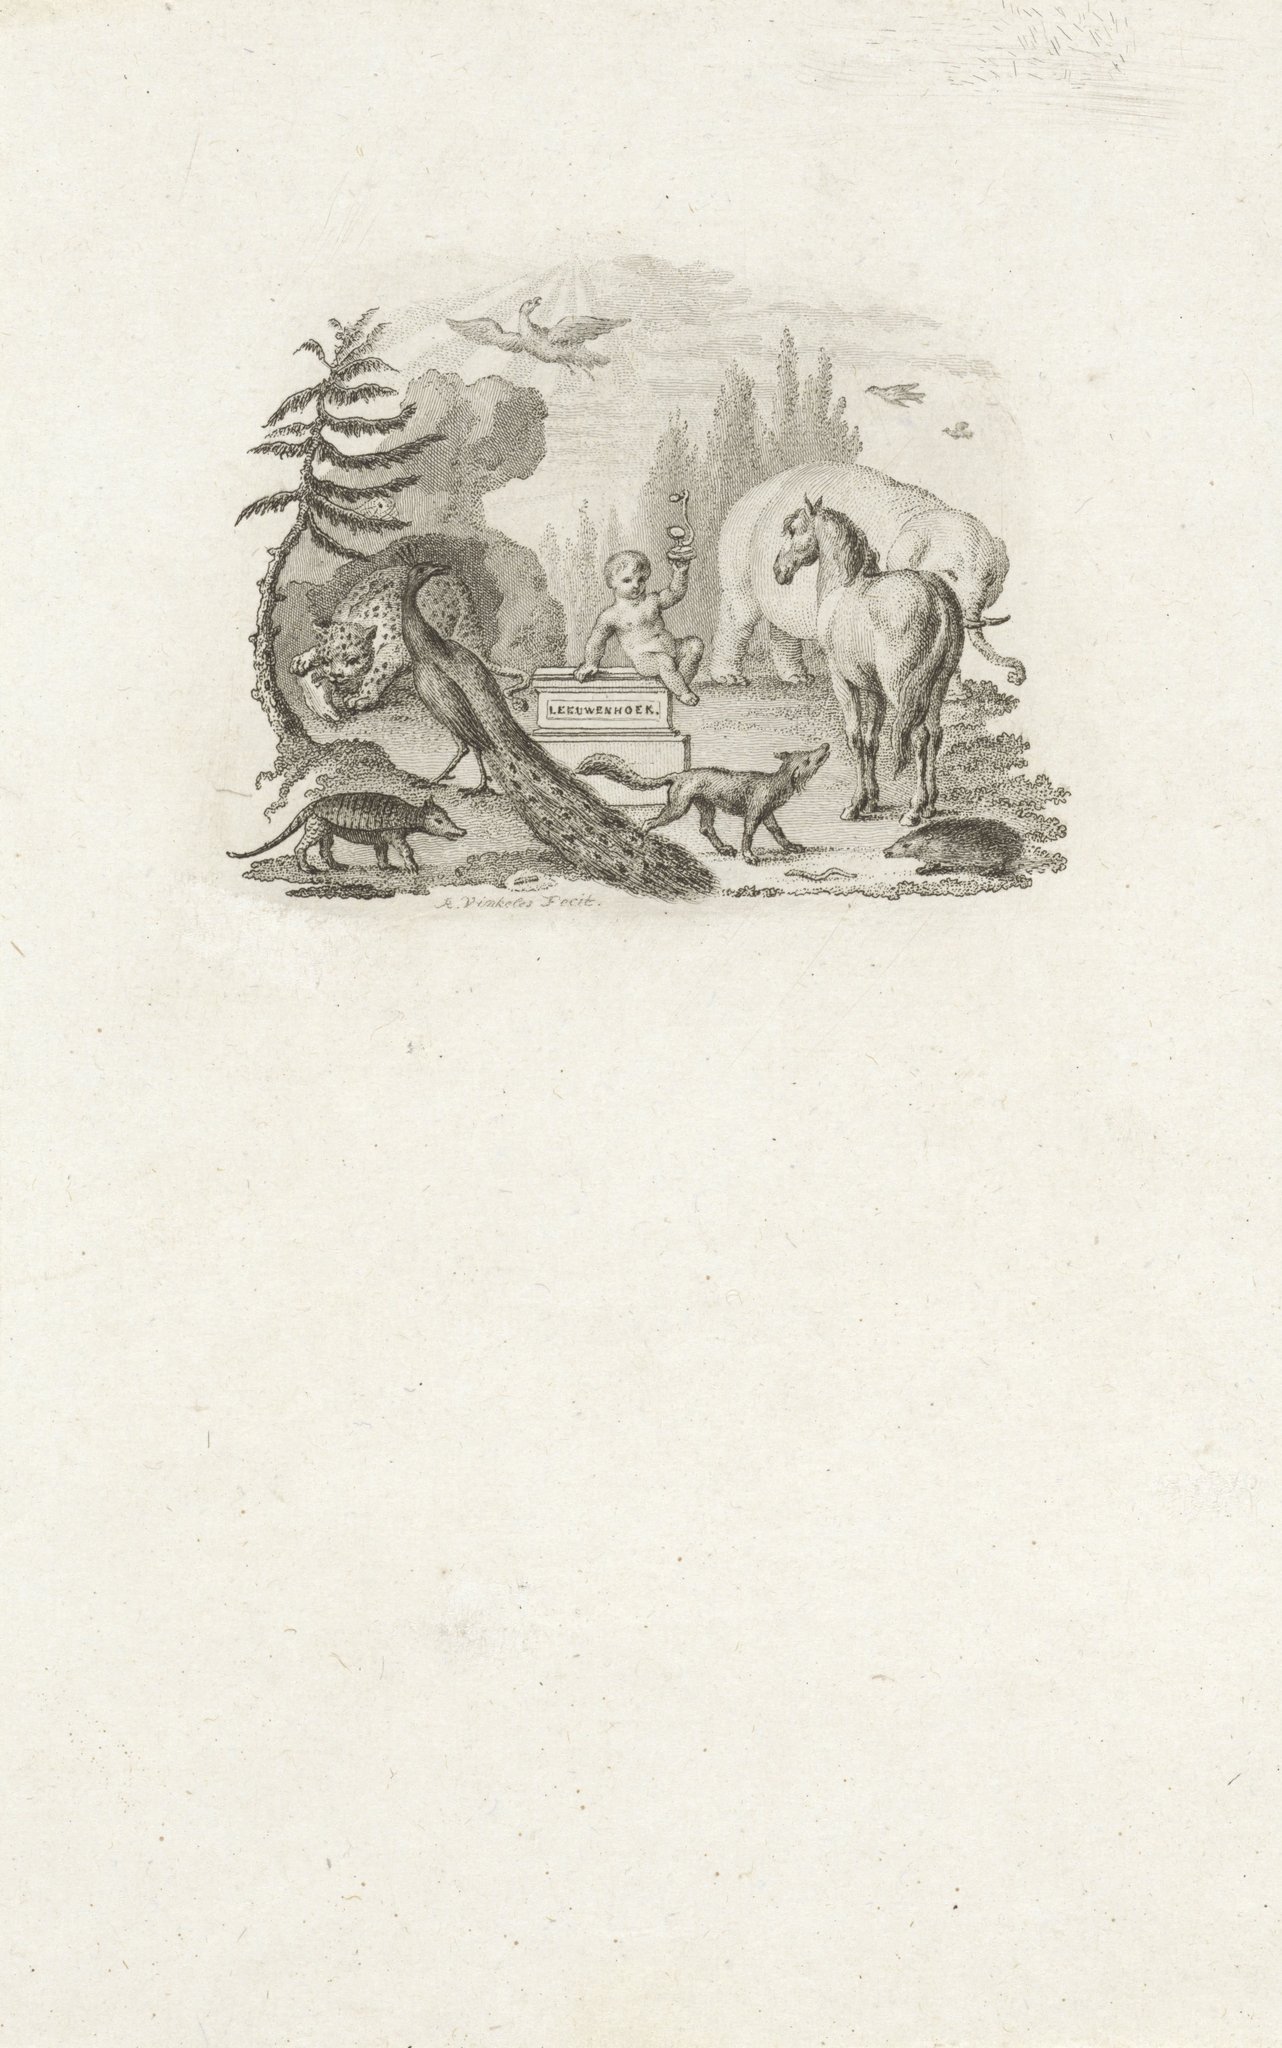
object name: print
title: Putto met een microscoop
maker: reinier vinkeles (i)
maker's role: draughtsman, print maker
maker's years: 1741-1816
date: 1751-1816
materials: paper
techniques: engraving, etching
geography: amsterdam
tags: delft, physicist, anthony van leeuwenhoek, landscapes, animals, cupids: 'amores', 'amoretti', 'putti', microscope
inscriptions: collector's mark: Lugt 2228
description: In een landschap zit een putto met een microscoop op een voetstuk waarop 'Leeuwenhoek' staat. Hij is omringd door verschillende dieren.